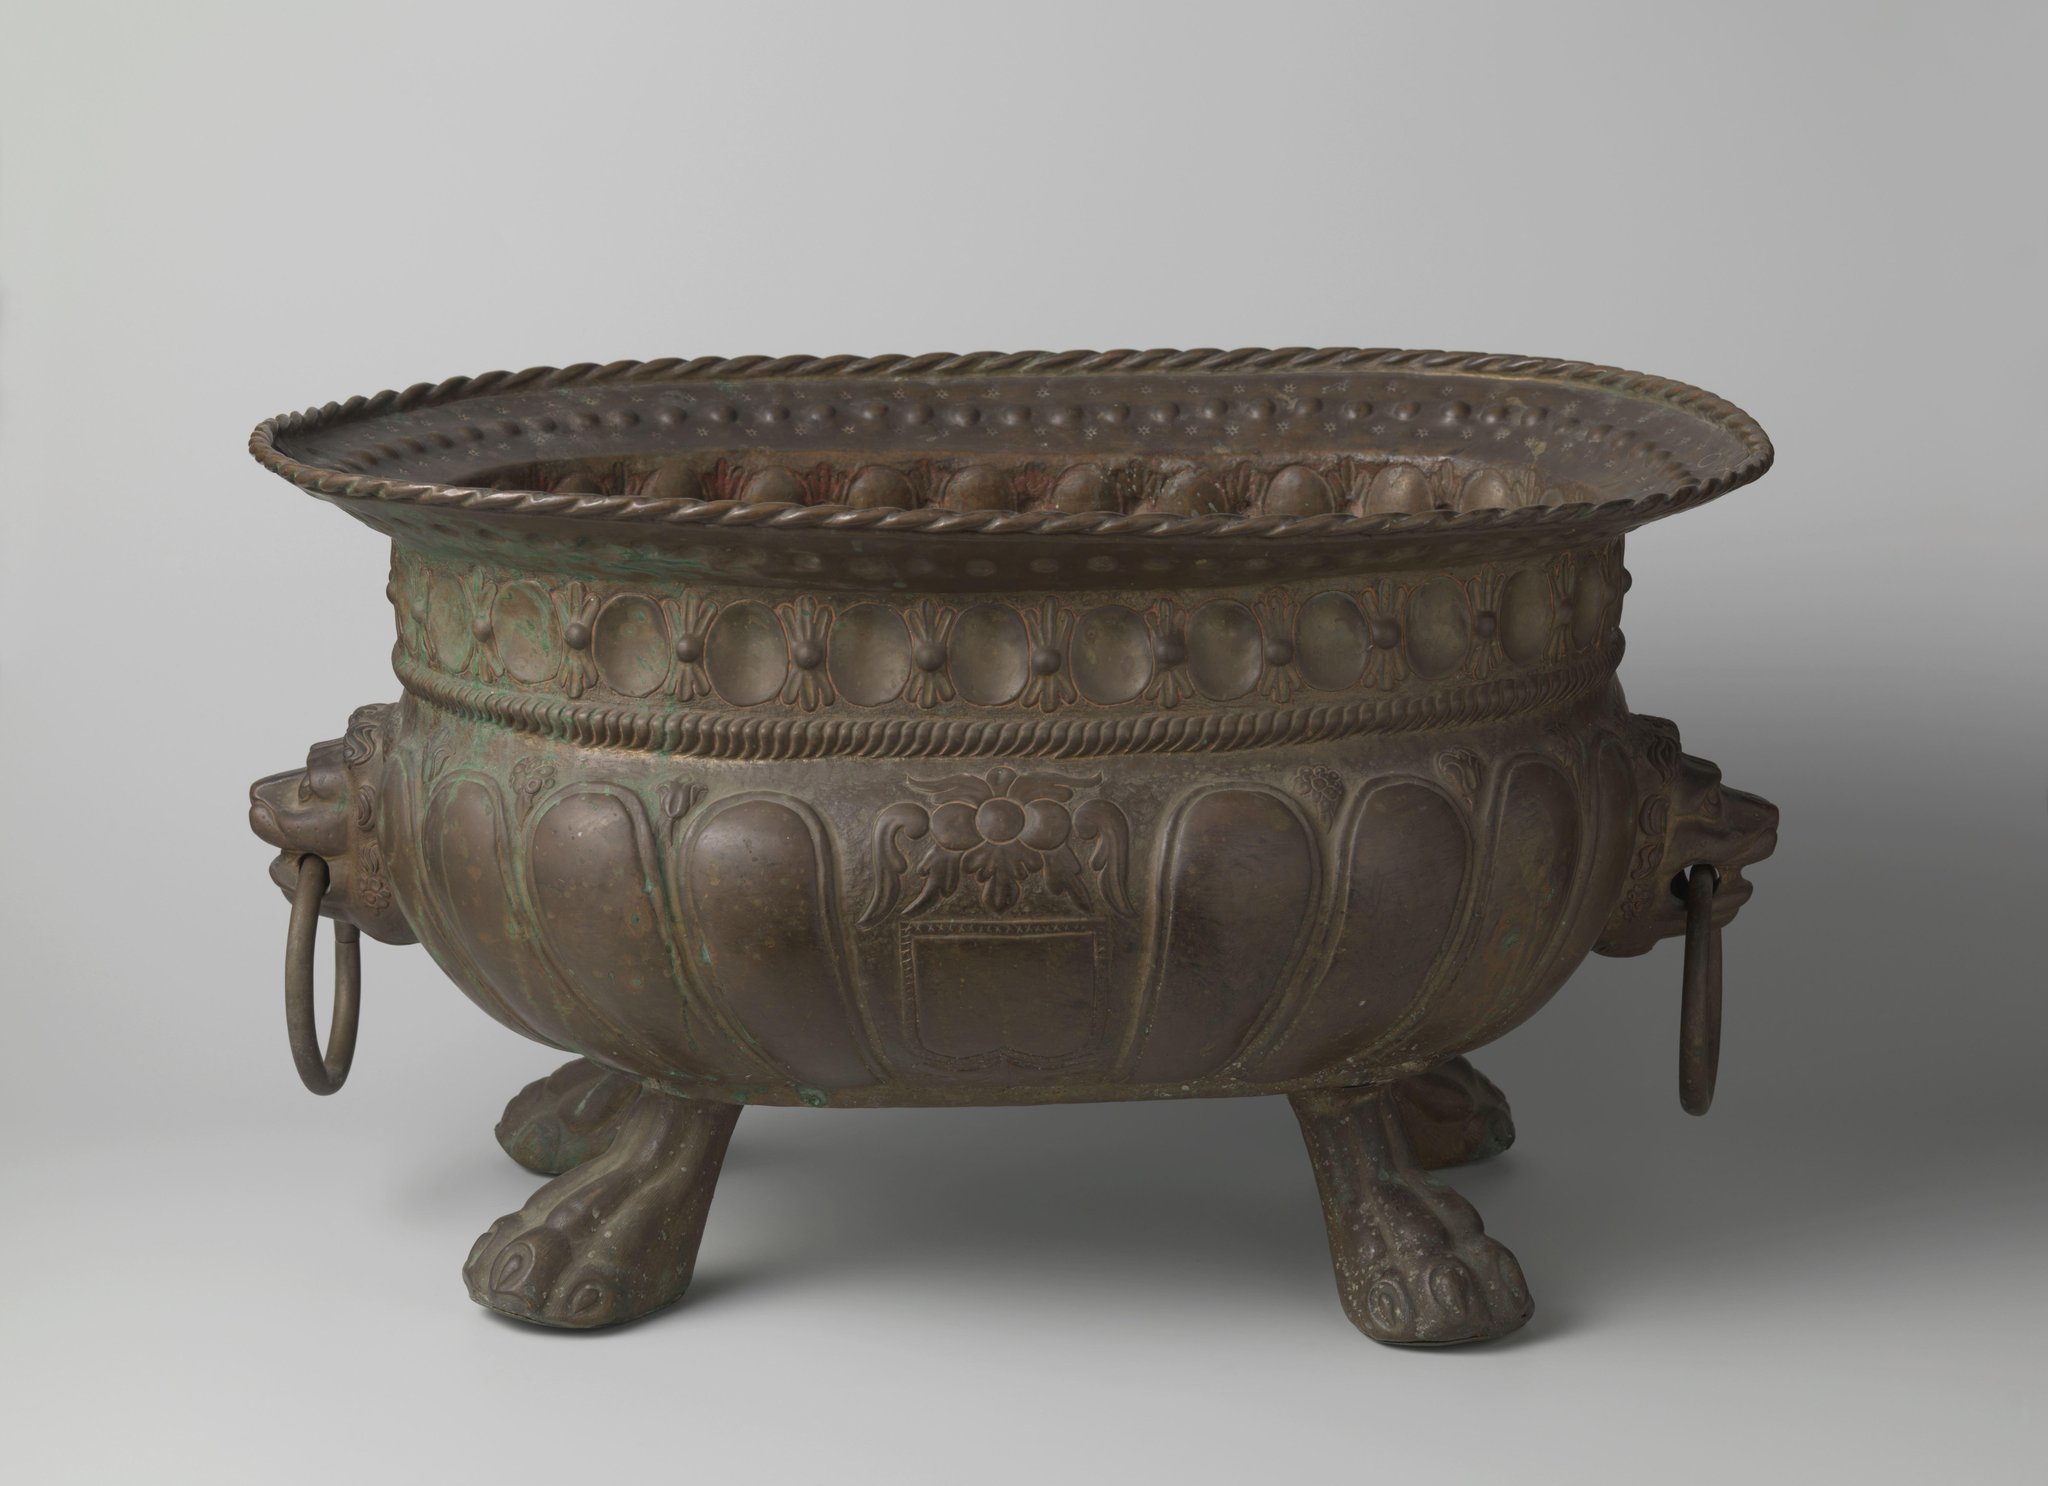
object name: wine cooler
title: Koelvat met op de lange zijden een blank wapenschild omgeven door vier godrons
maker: Anonymous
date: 1600-1650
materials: brass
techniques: brazing, punching, riveted, soldering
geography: netherlands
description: Met uitzondering van de twee uit stangen vervaardigde ringen bestaat het voorwerp uit de volgende uit plaat gedreven delen: de bak, die de indruk maakt uit één plaat te zijn gemaakt; de daaraan gebraseerde twee leeuwekoppen, de viet poten, waaraan tegen de onderkant vier platen zijn gebraseerd. De bak heeft een gedreven decor met op de lange zijden in het midden een blank wapenschild waarboven gestileerd rankenwerk, en links en rechts omgeven door vier godrons. De opstaande rand heeft een koordrand en een holle eierlijst. Het bovenste uitstekende boord van het vat heeft en decor met noppen en geponste stermotieven. De met ijzerdraad verstevigde rand is als een koord versierd. De wand is hier en daar met lood of tin gesoldeerd. In het boord bevinden zich aan beide korte kanten telkens drie dichtgeklonken gaten.